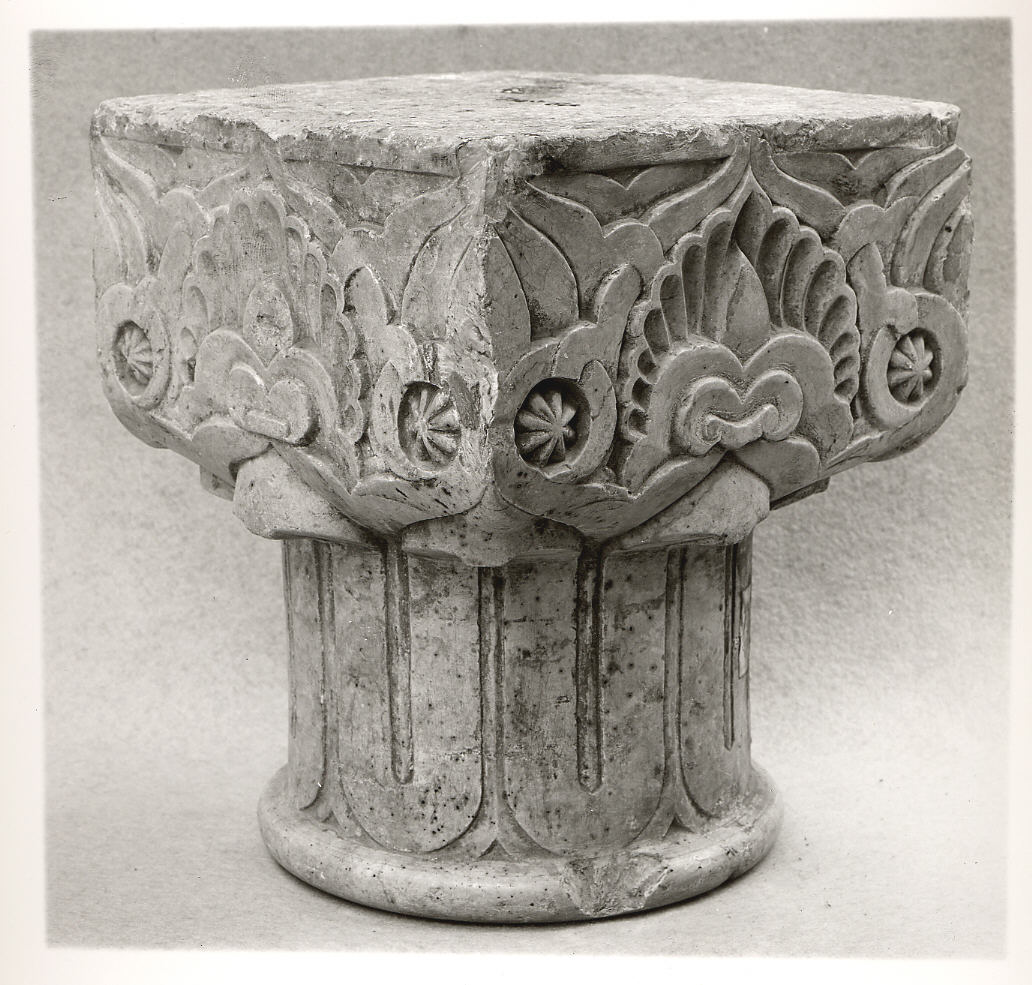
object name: capital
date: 1401-1500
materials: marble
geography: spain